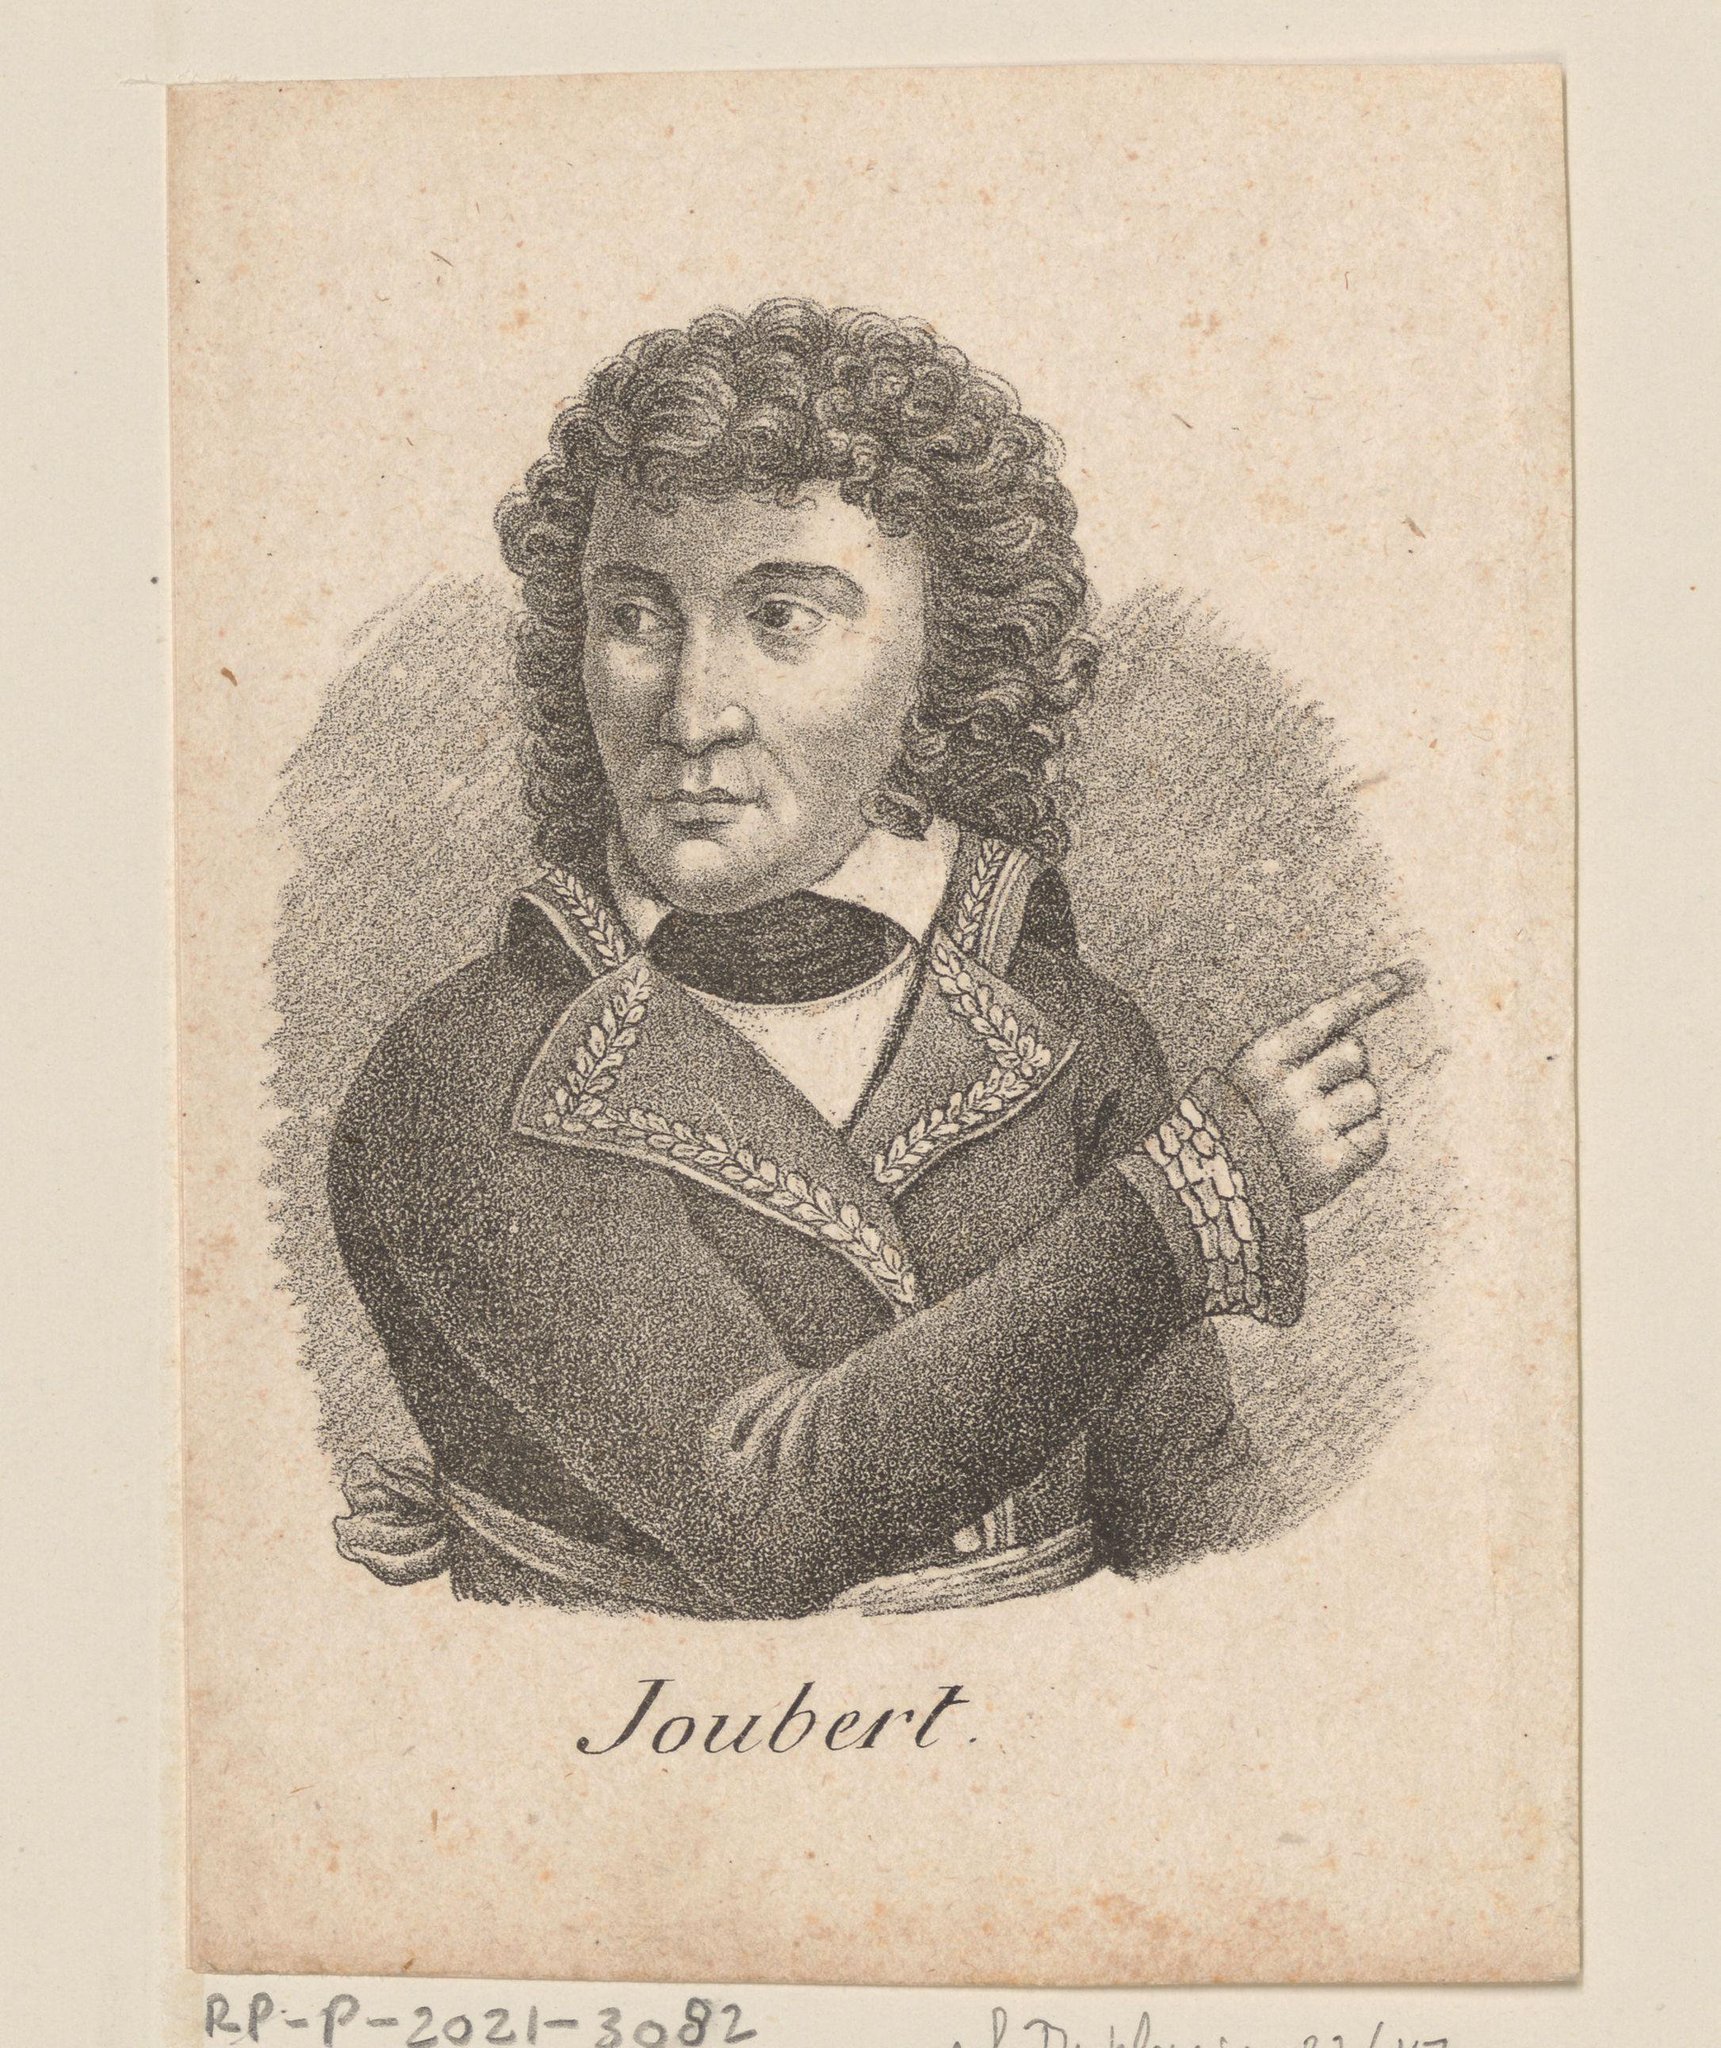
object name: print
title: Portret van Barthélémy Catherine Joubert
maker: Anonymous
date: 1800-1849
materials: paper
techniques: lithograph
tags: commander-in-chief, general, marshal, historical persons